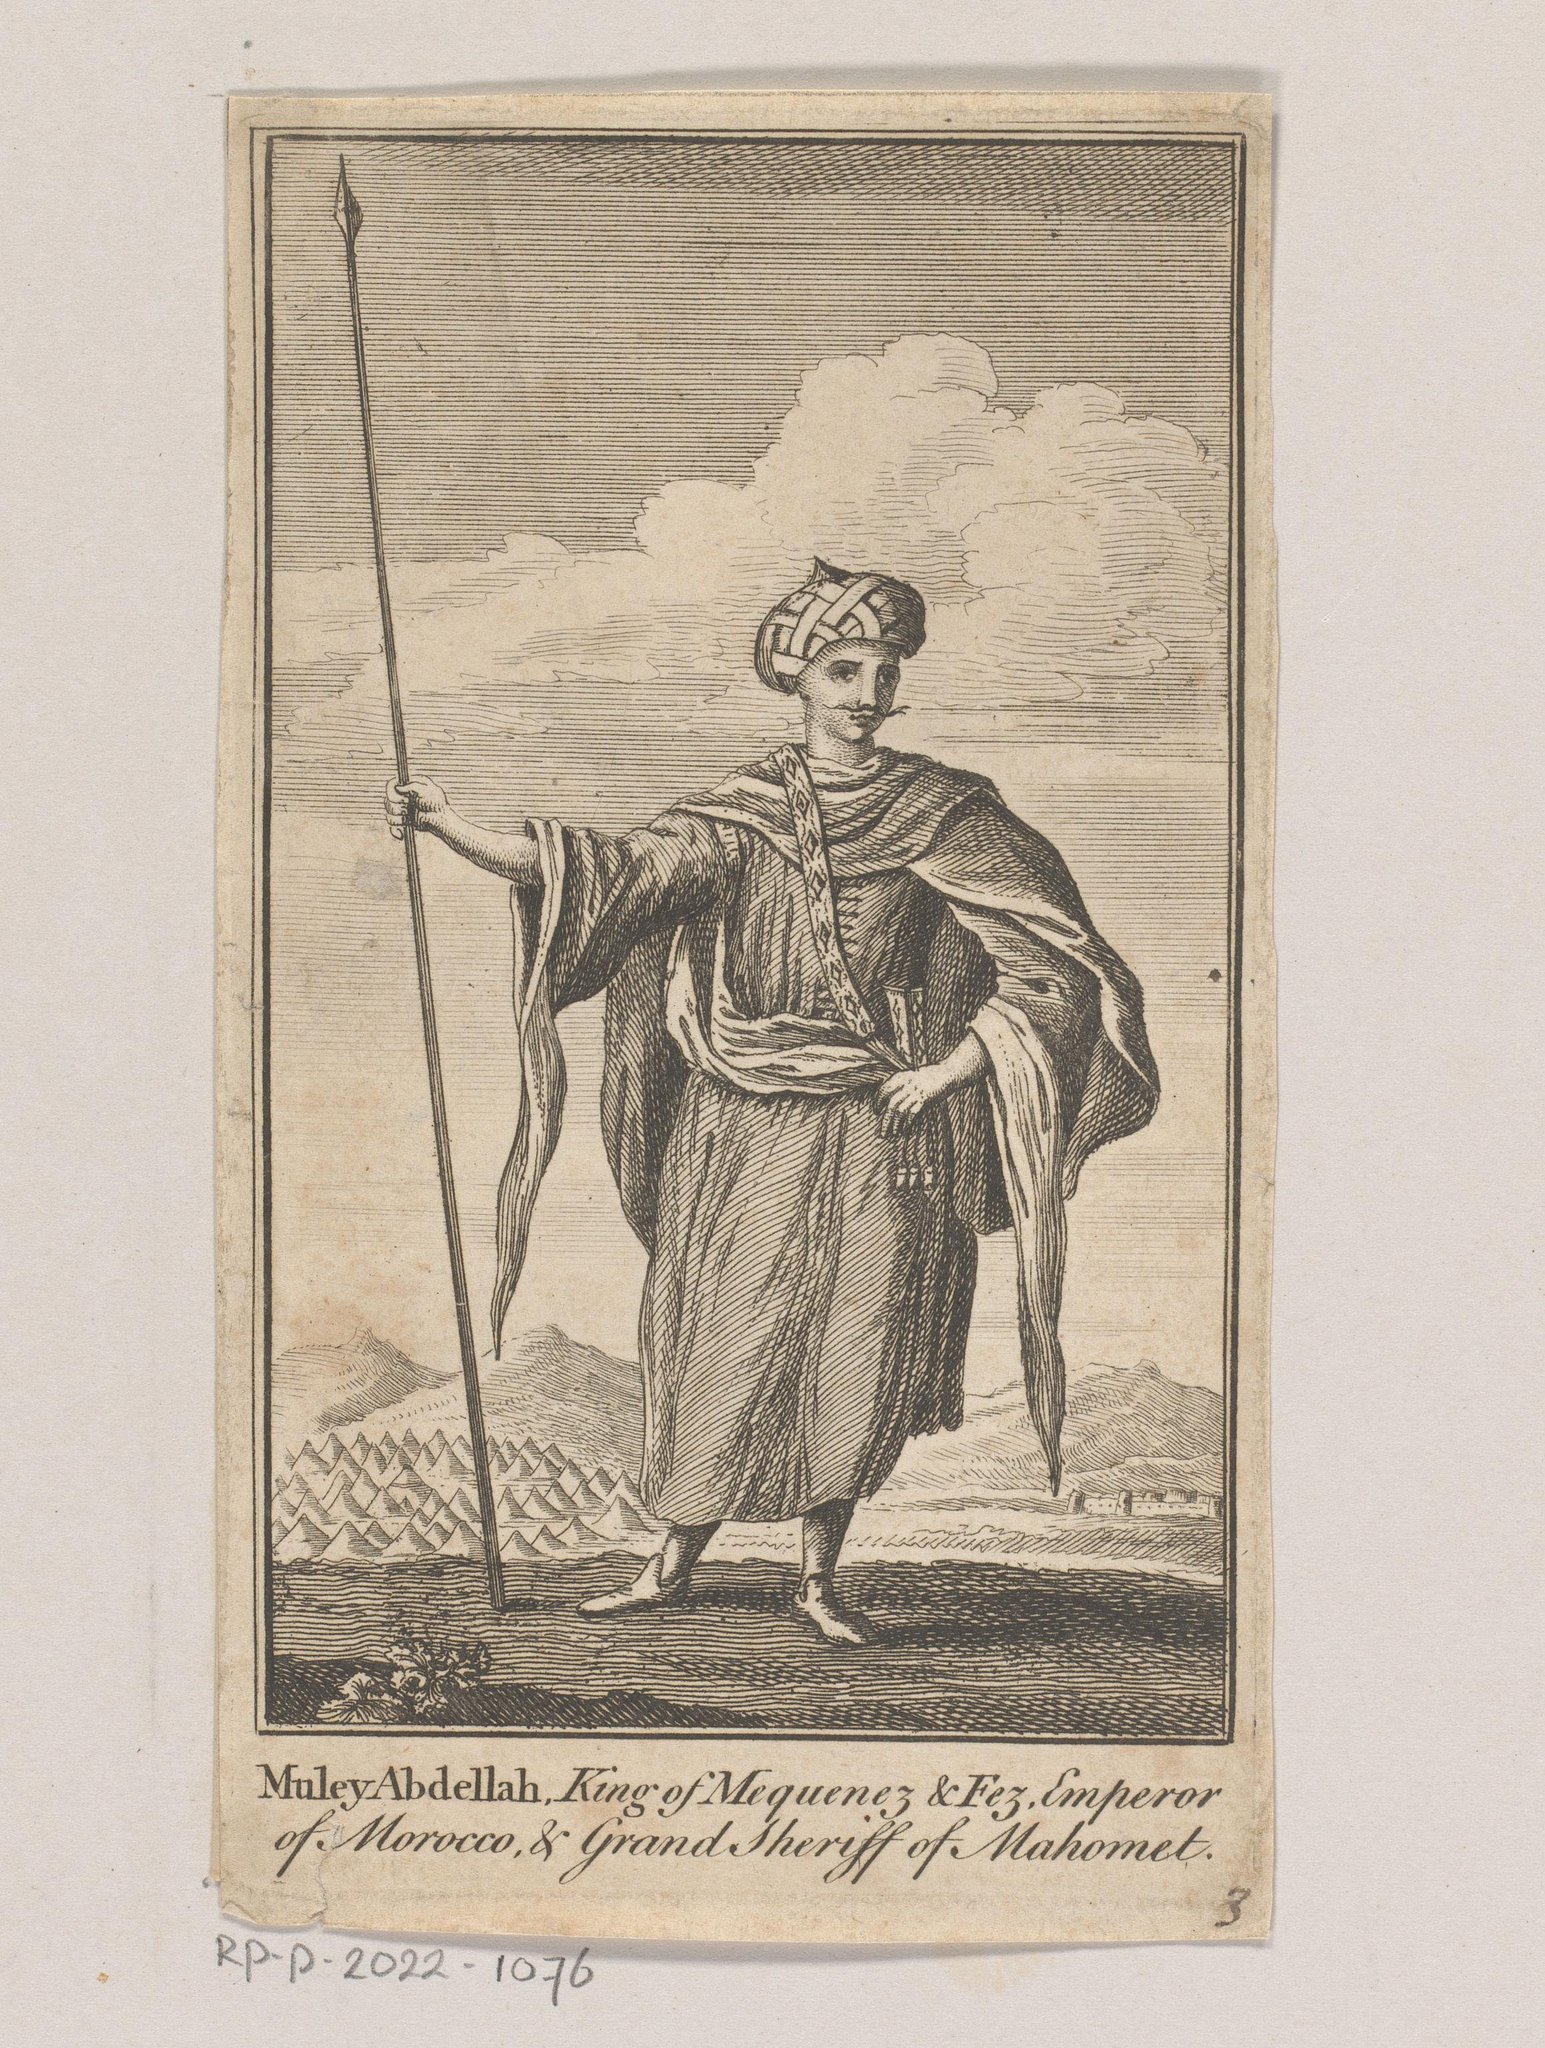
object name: print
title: Portret van Moulay Abdallah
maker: Anonymous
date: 1729-1799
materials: paper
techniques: etching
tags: politician, historical persons, other sovereign (with title)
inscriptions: number: ‘3’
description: Met tweeregelig onderschrift in het Engels.